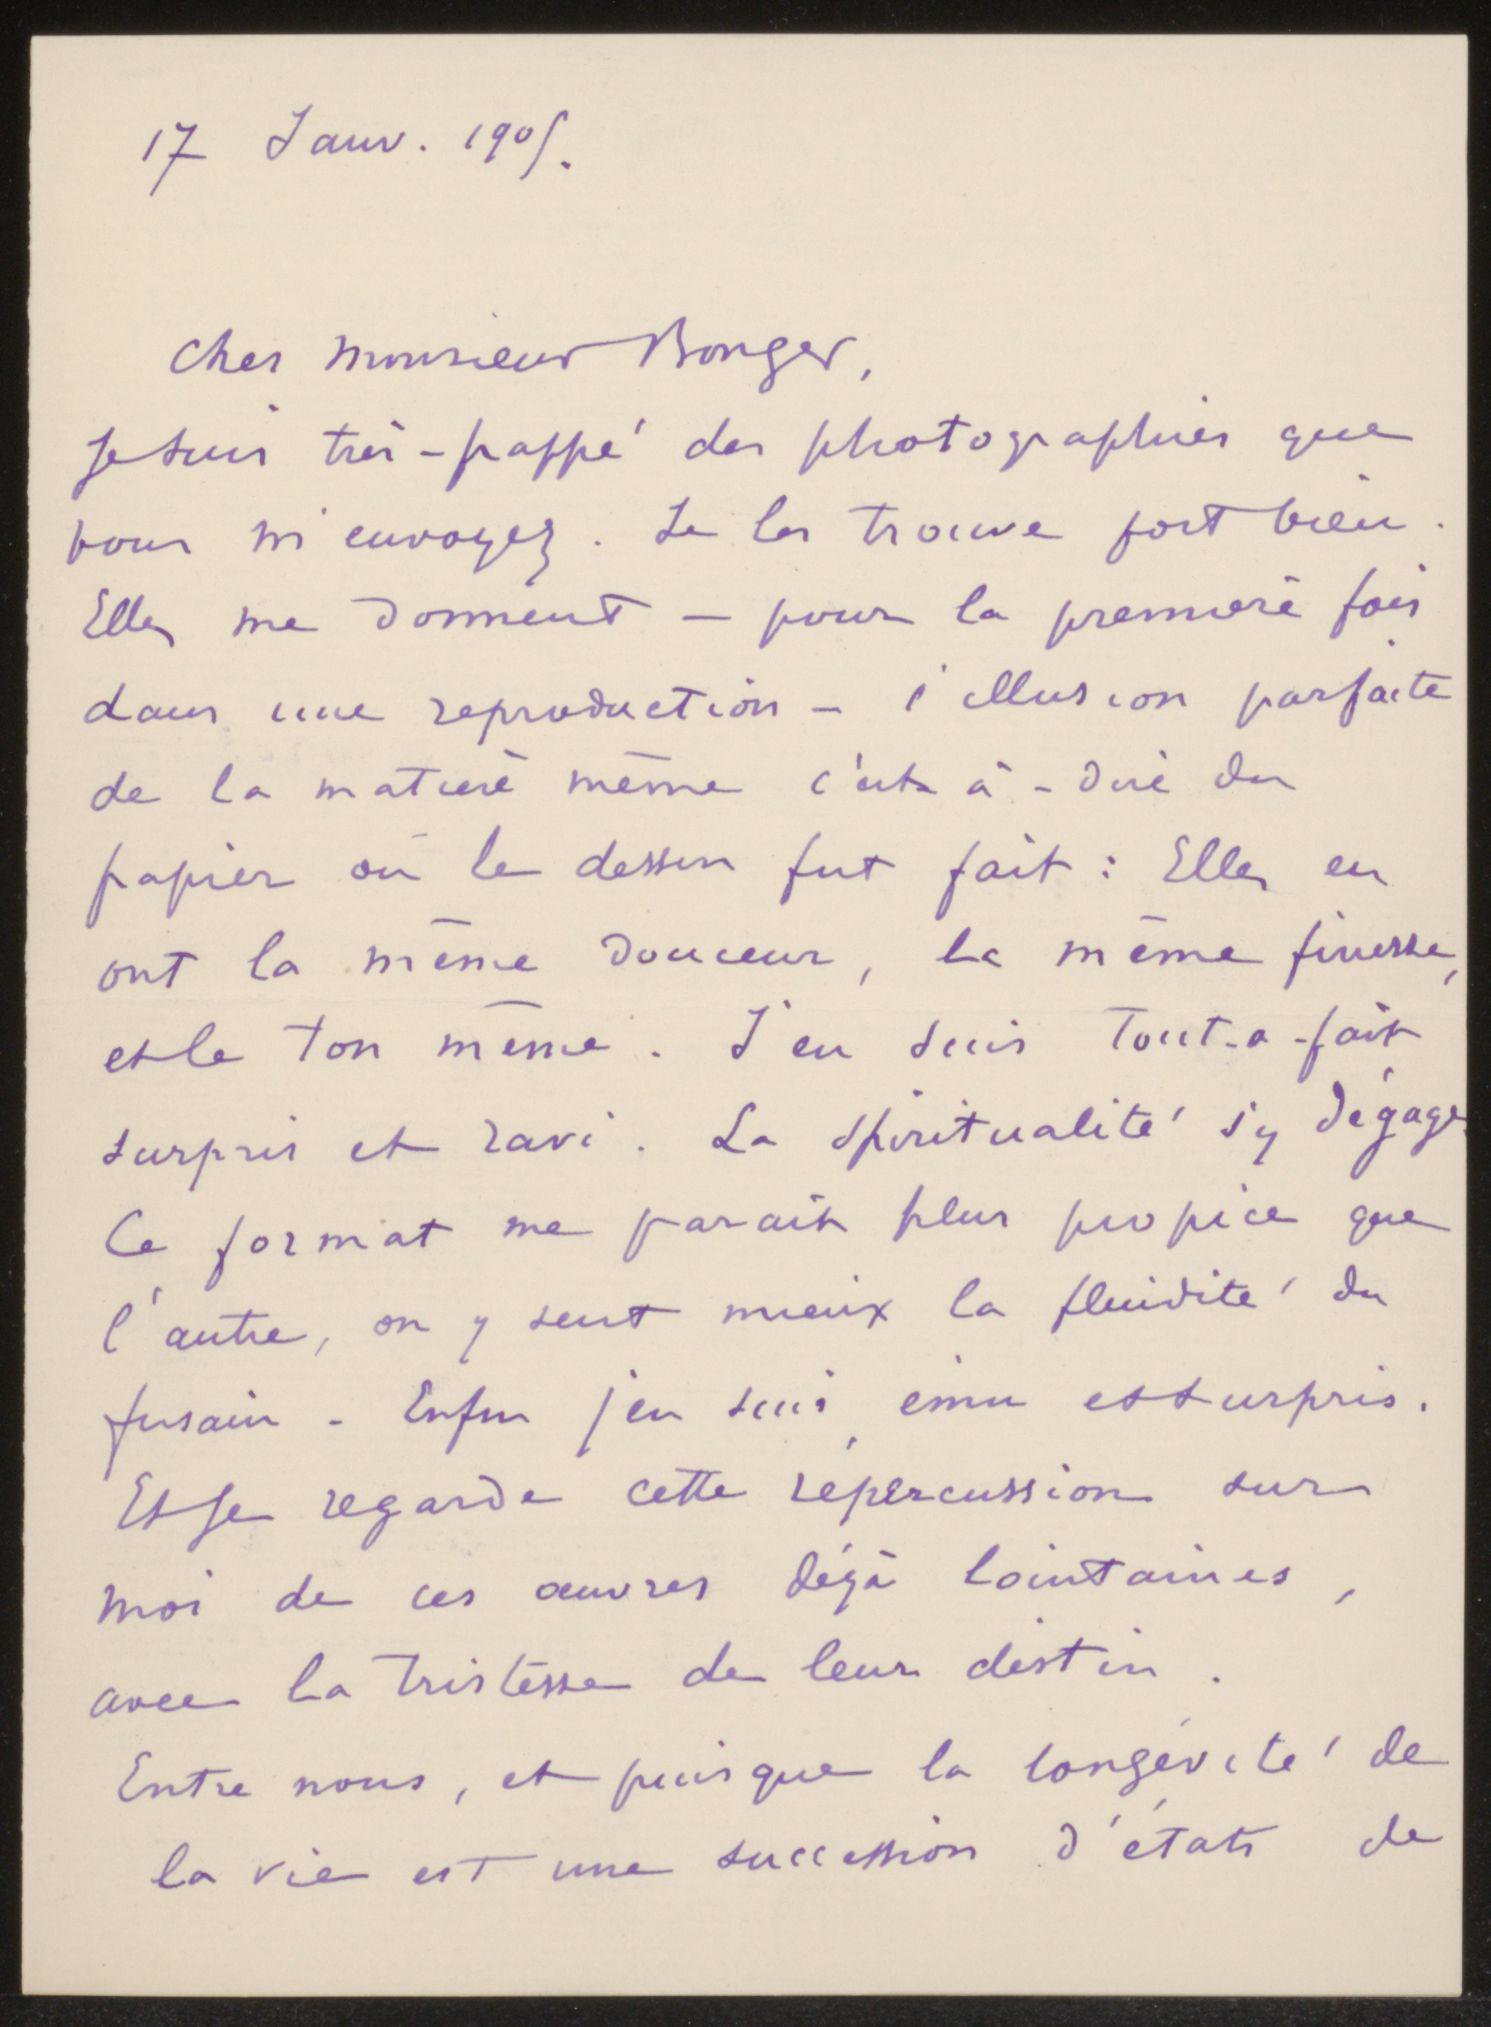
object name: letter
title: Brief aan Andries Bonger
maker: odilon redon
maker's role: draughtsman, painter, print maker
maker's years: 1840-1916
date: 1905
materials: ink, paper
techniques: pen, writing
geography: paris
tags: lyon, politician, bruges, jan van eyck, leiden, amsterdam, rembrandt van rijn, andries bonger, willem jan gerrit van meurs, drawing, photography, cinematography, exhibition ~ art, printed matter